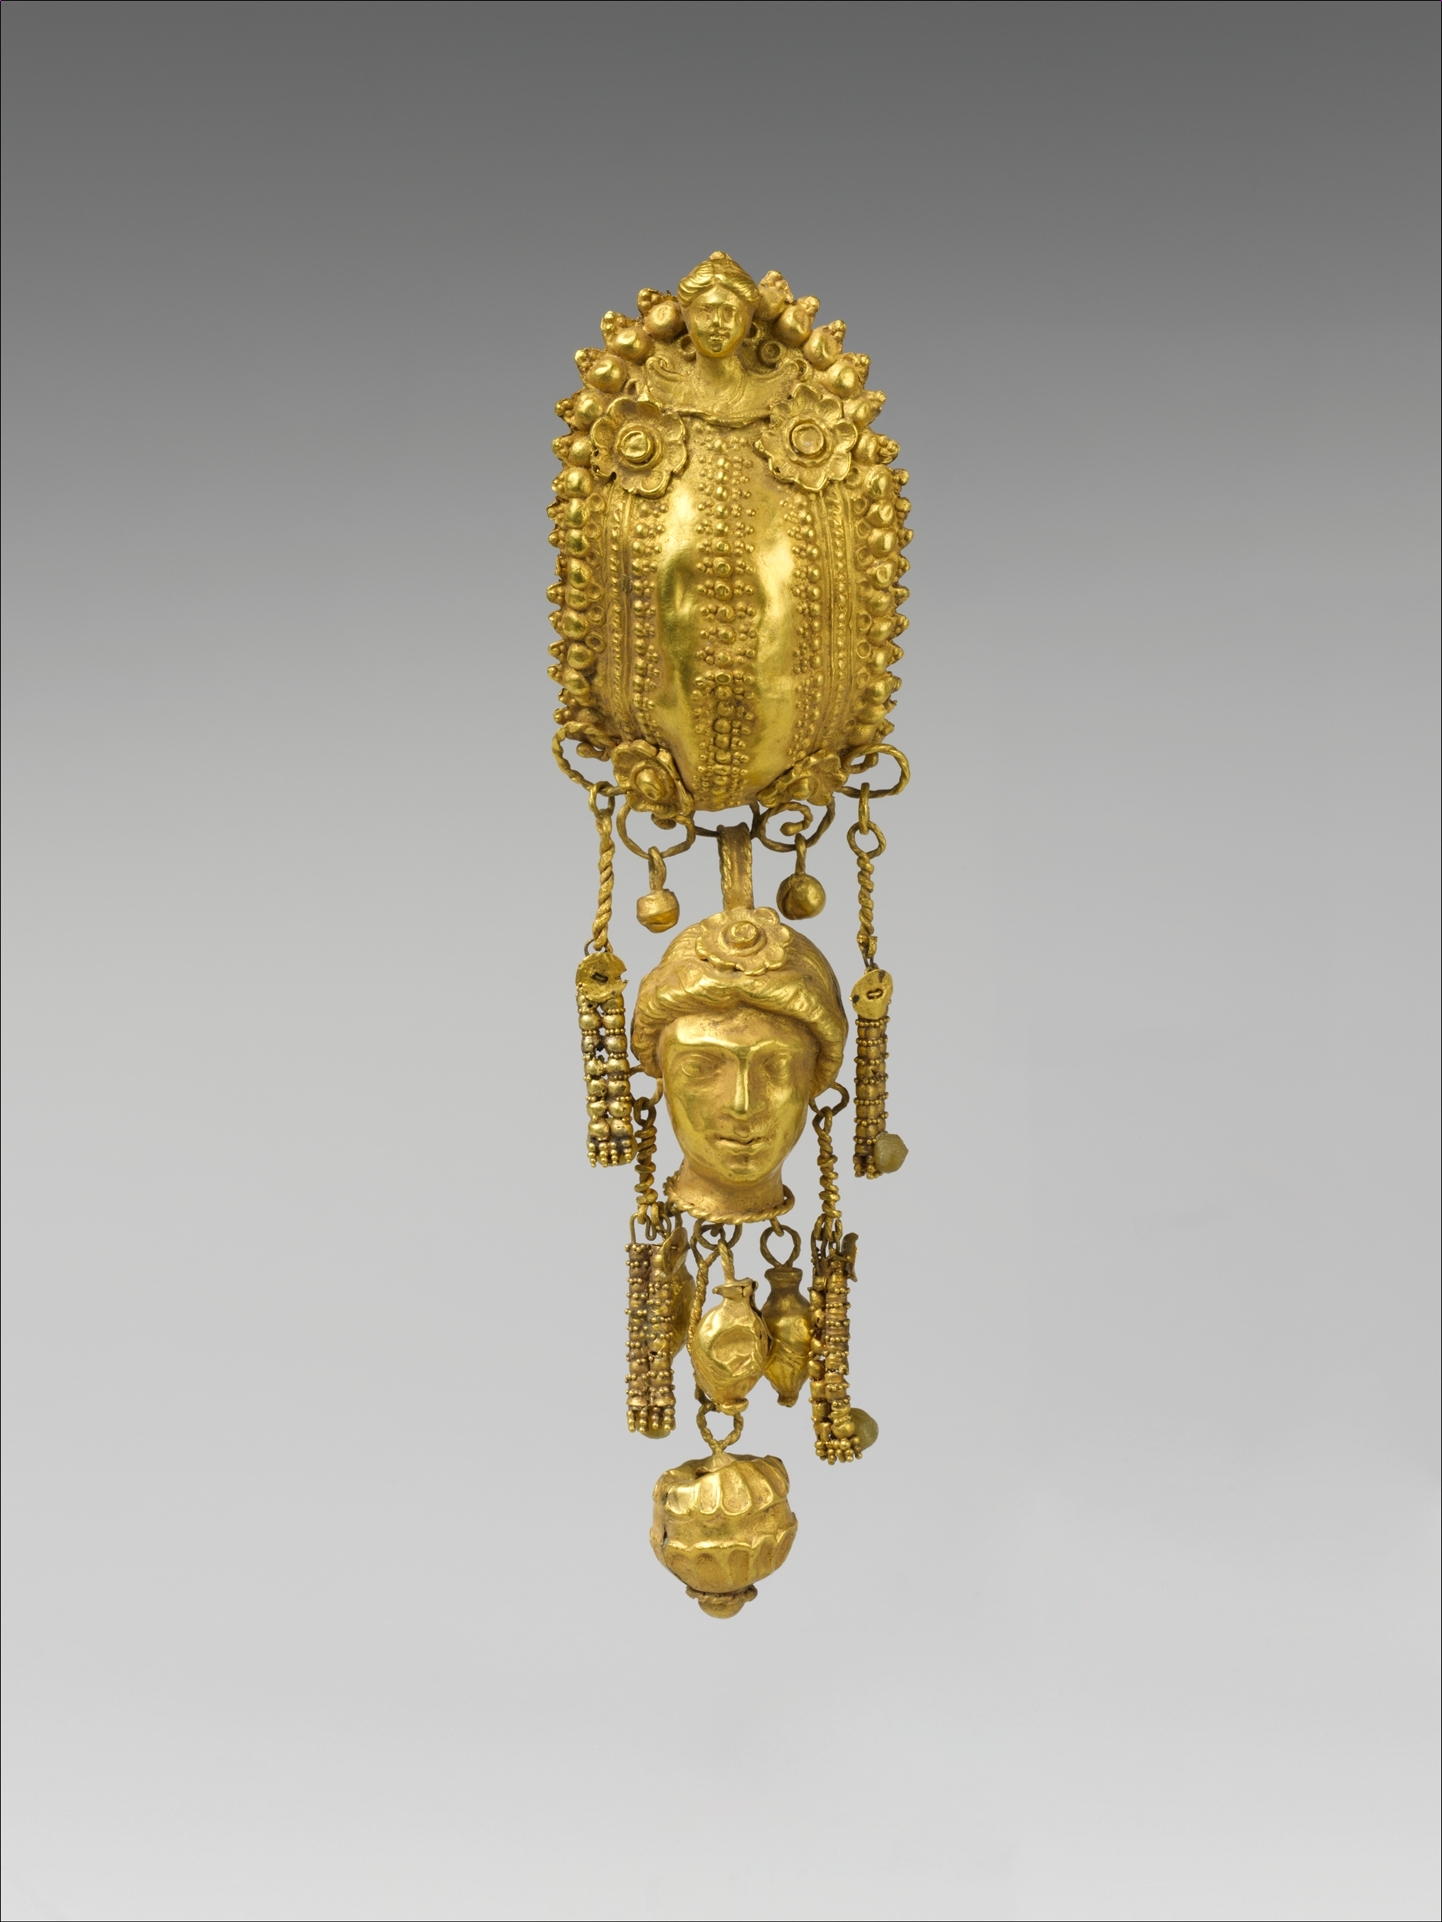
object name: earring with nail head pendant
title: Earring with pendants and female head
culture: etruscan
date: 300-201 BCE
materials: gold, silver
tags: heads,women